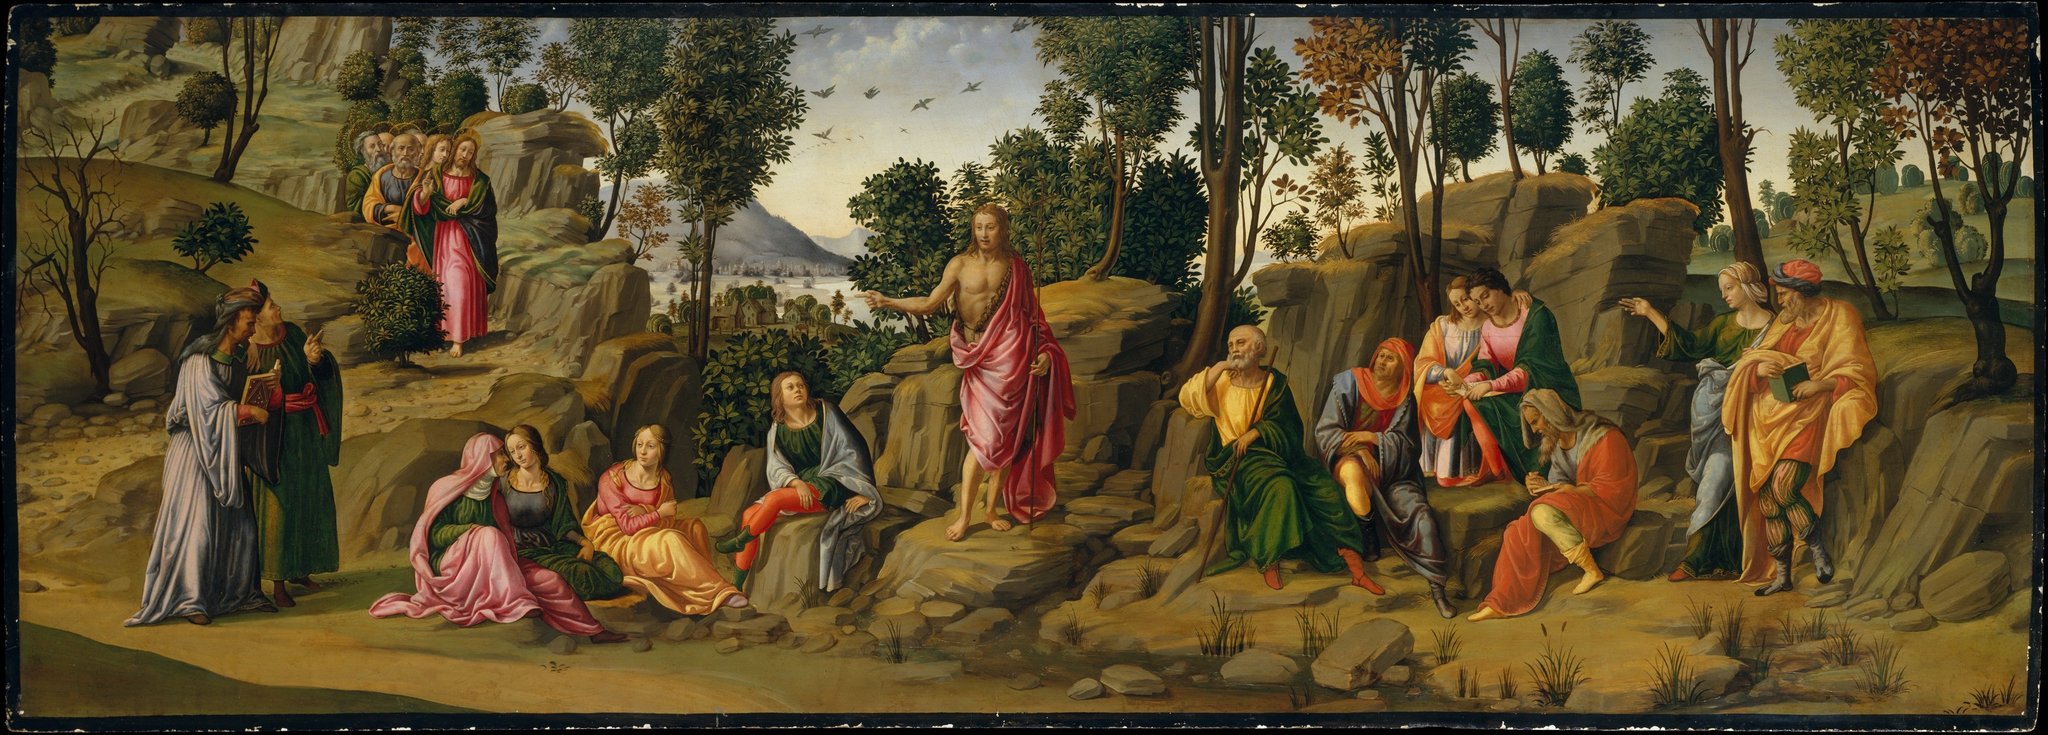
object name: painting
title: Saint John the Baptist Bearing Witness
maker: francesco granacci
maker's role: artist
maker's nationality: italian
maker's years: 1469-1543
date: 1506-1507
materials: gold, oil, wood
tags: men,women,christ,saint john the baptist